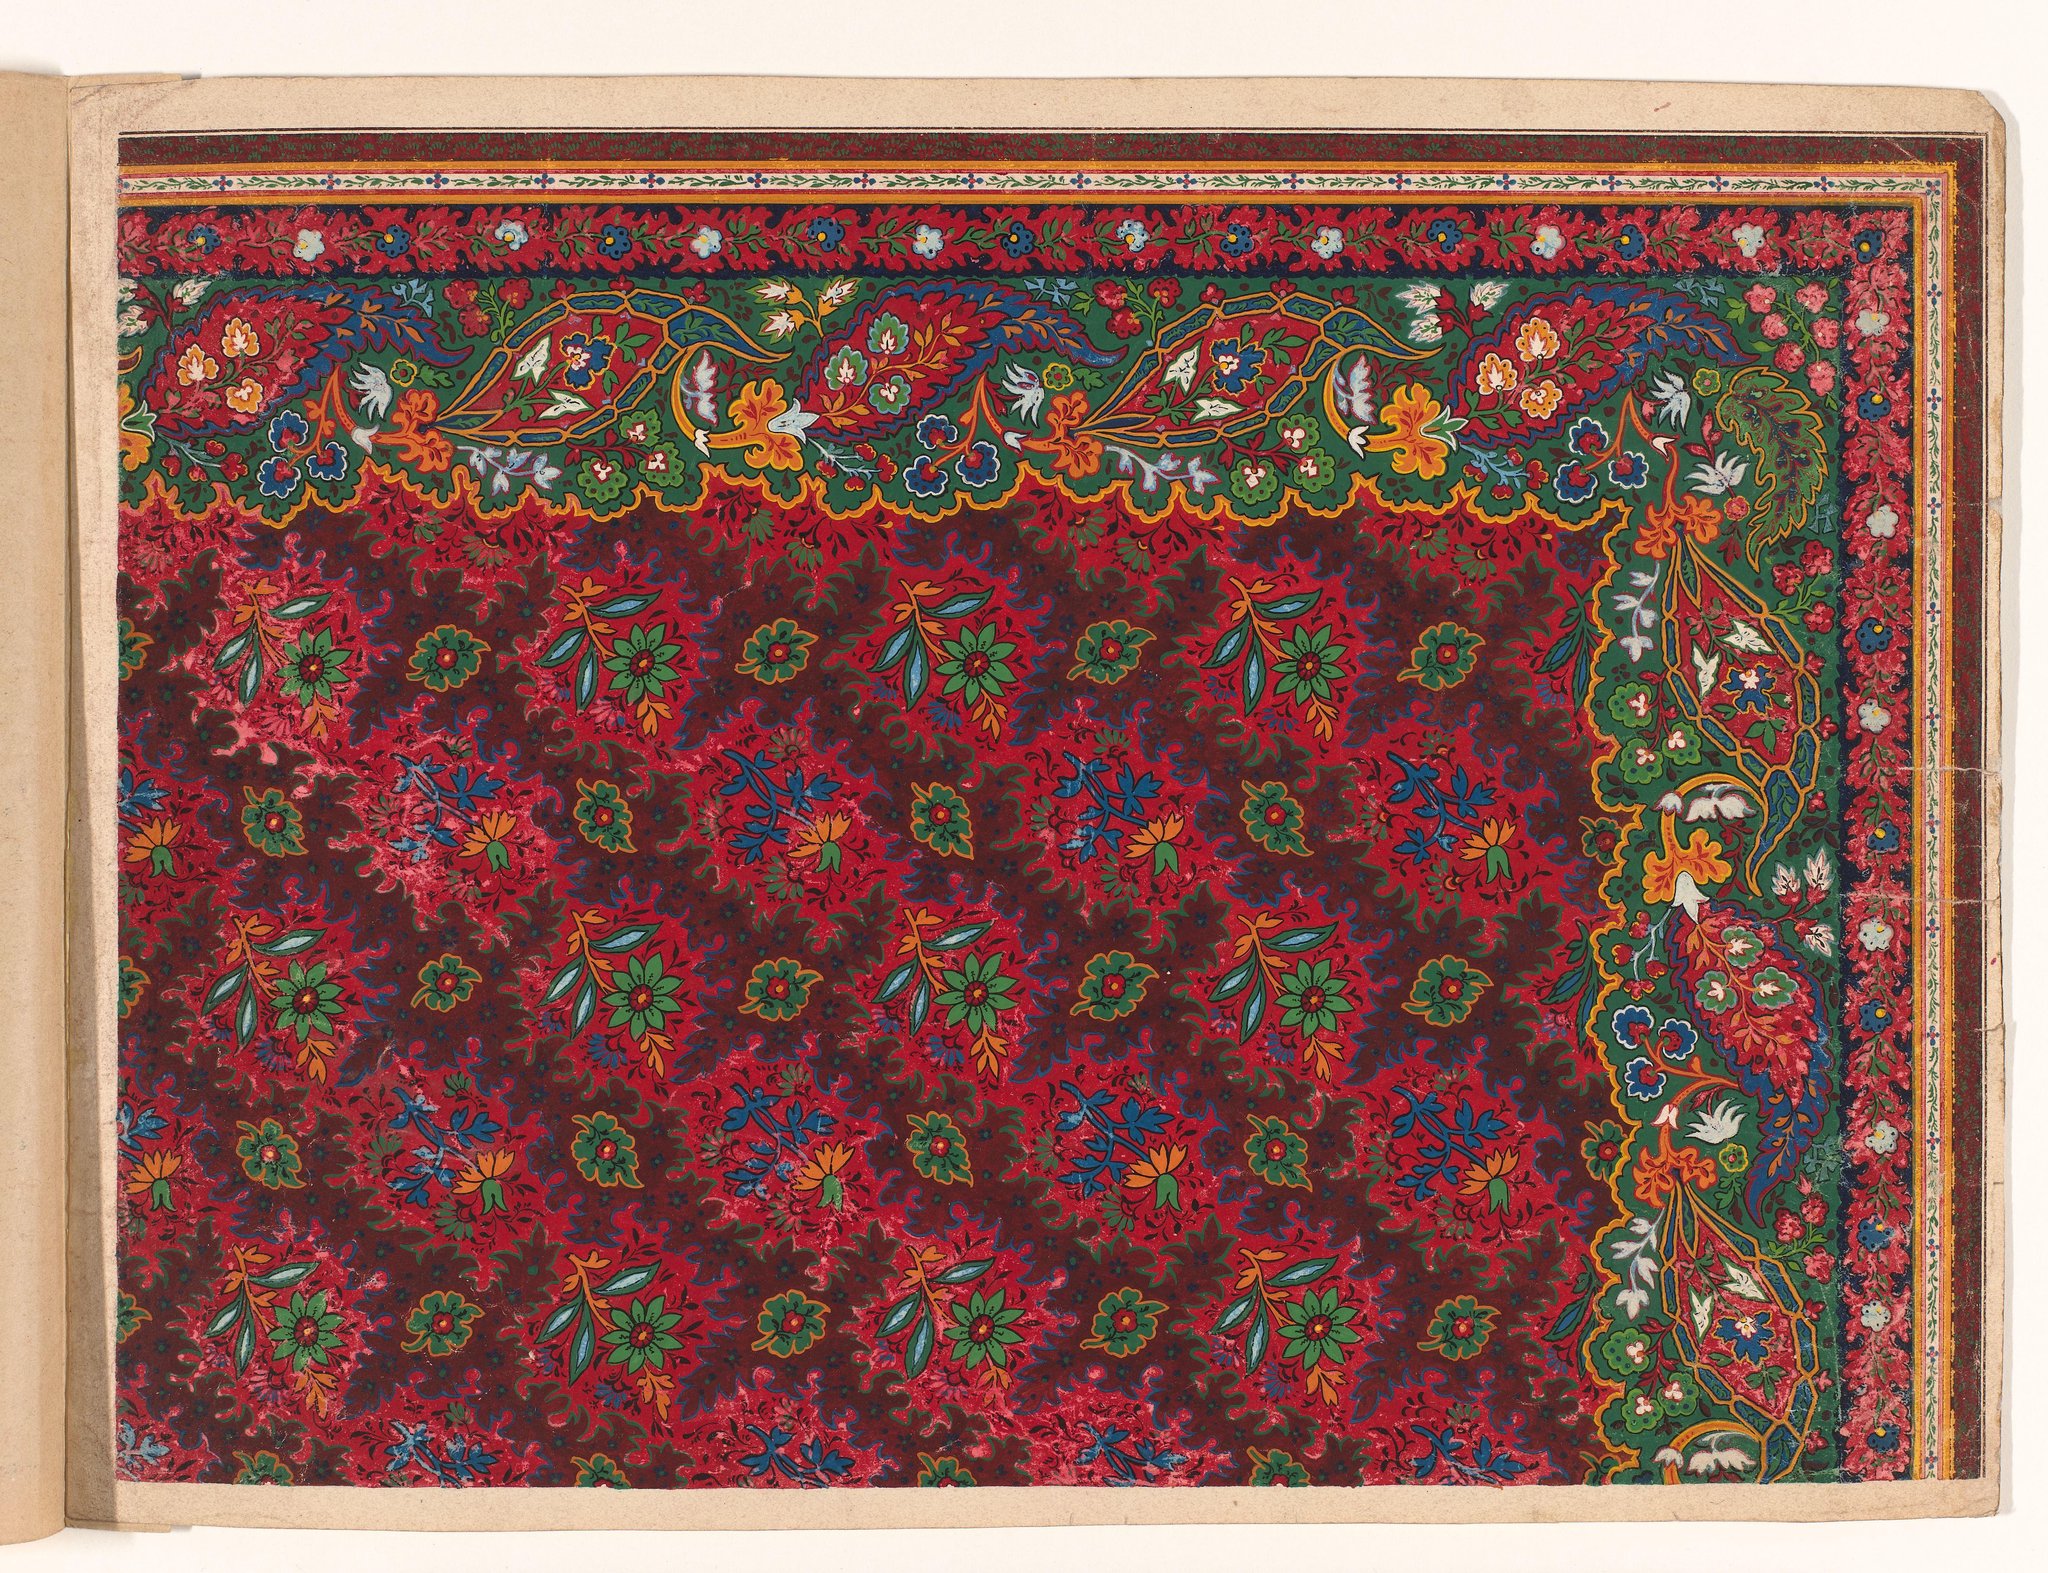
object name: design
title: Ontwerp voor een tapijt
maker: Anonymous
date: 1854-1864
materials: gouache, paper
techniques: brush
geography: deventer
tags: ornaments ~ art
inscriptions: inscription: ‘R’, retailer's mark: ‘JHS.’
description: De presentatietekeningen BK-1971-77-1 t/m 86 zijn kopieën van de originele ontwerptekeningen. Ze werden gemaakt voor vertegenwoordigers van bijvoorbeeld magazijnen, die ze aan hun klanten konden tonen. De meeste tekeningen tonen een kwart van het dessin inclusief rand, middenpartij (de zogenaamde grond of fond) en centraal medaillon. Door het gebruik van spiegels kan de illusie van het gehele tapijt worden opgeroepen. Een deel van de tekeningen heeft een alfabetische opeenvolgende letter als kenmerk, de andere groep een cijfer.Waarschijnlijk is de reeks dessins met een letter eerder samengesteld dan de genummerde tekeningen.